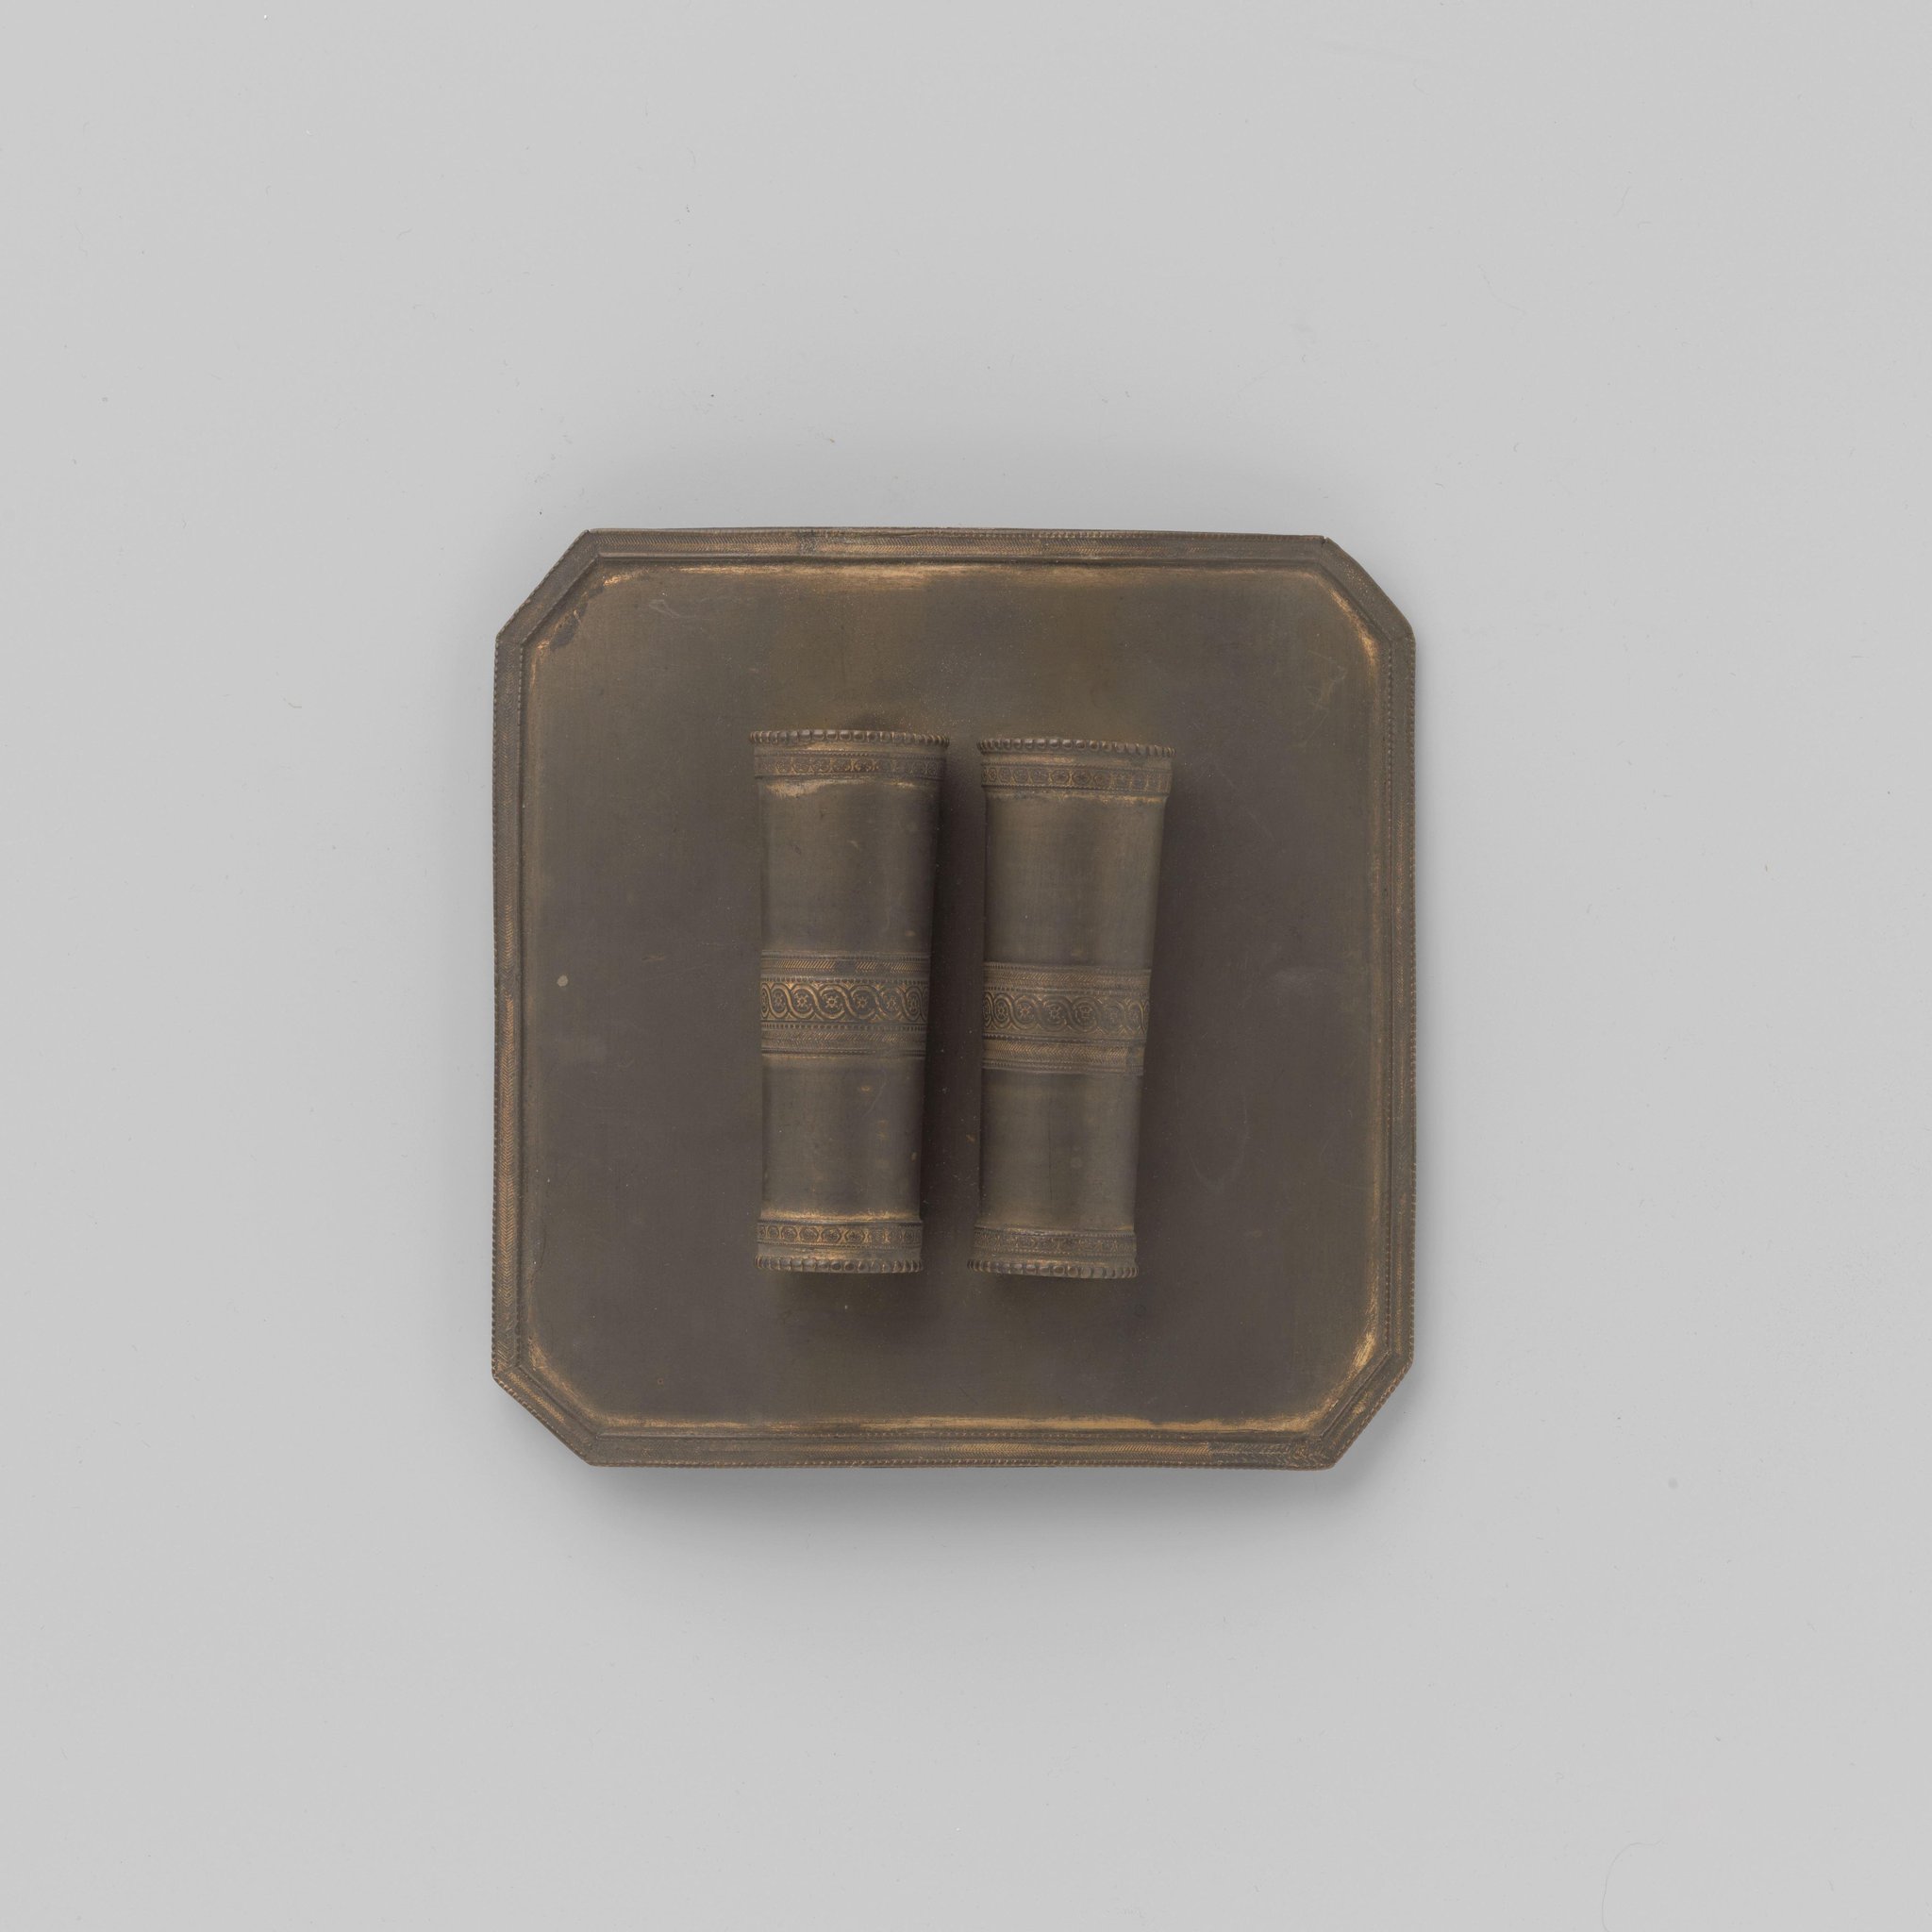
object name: percussion instrument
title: Drumstick holder from a drummers belt plate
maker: Anonymous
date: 1823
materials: copper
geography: netherlands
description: Stokplaat van messing voor tamboer-majoor